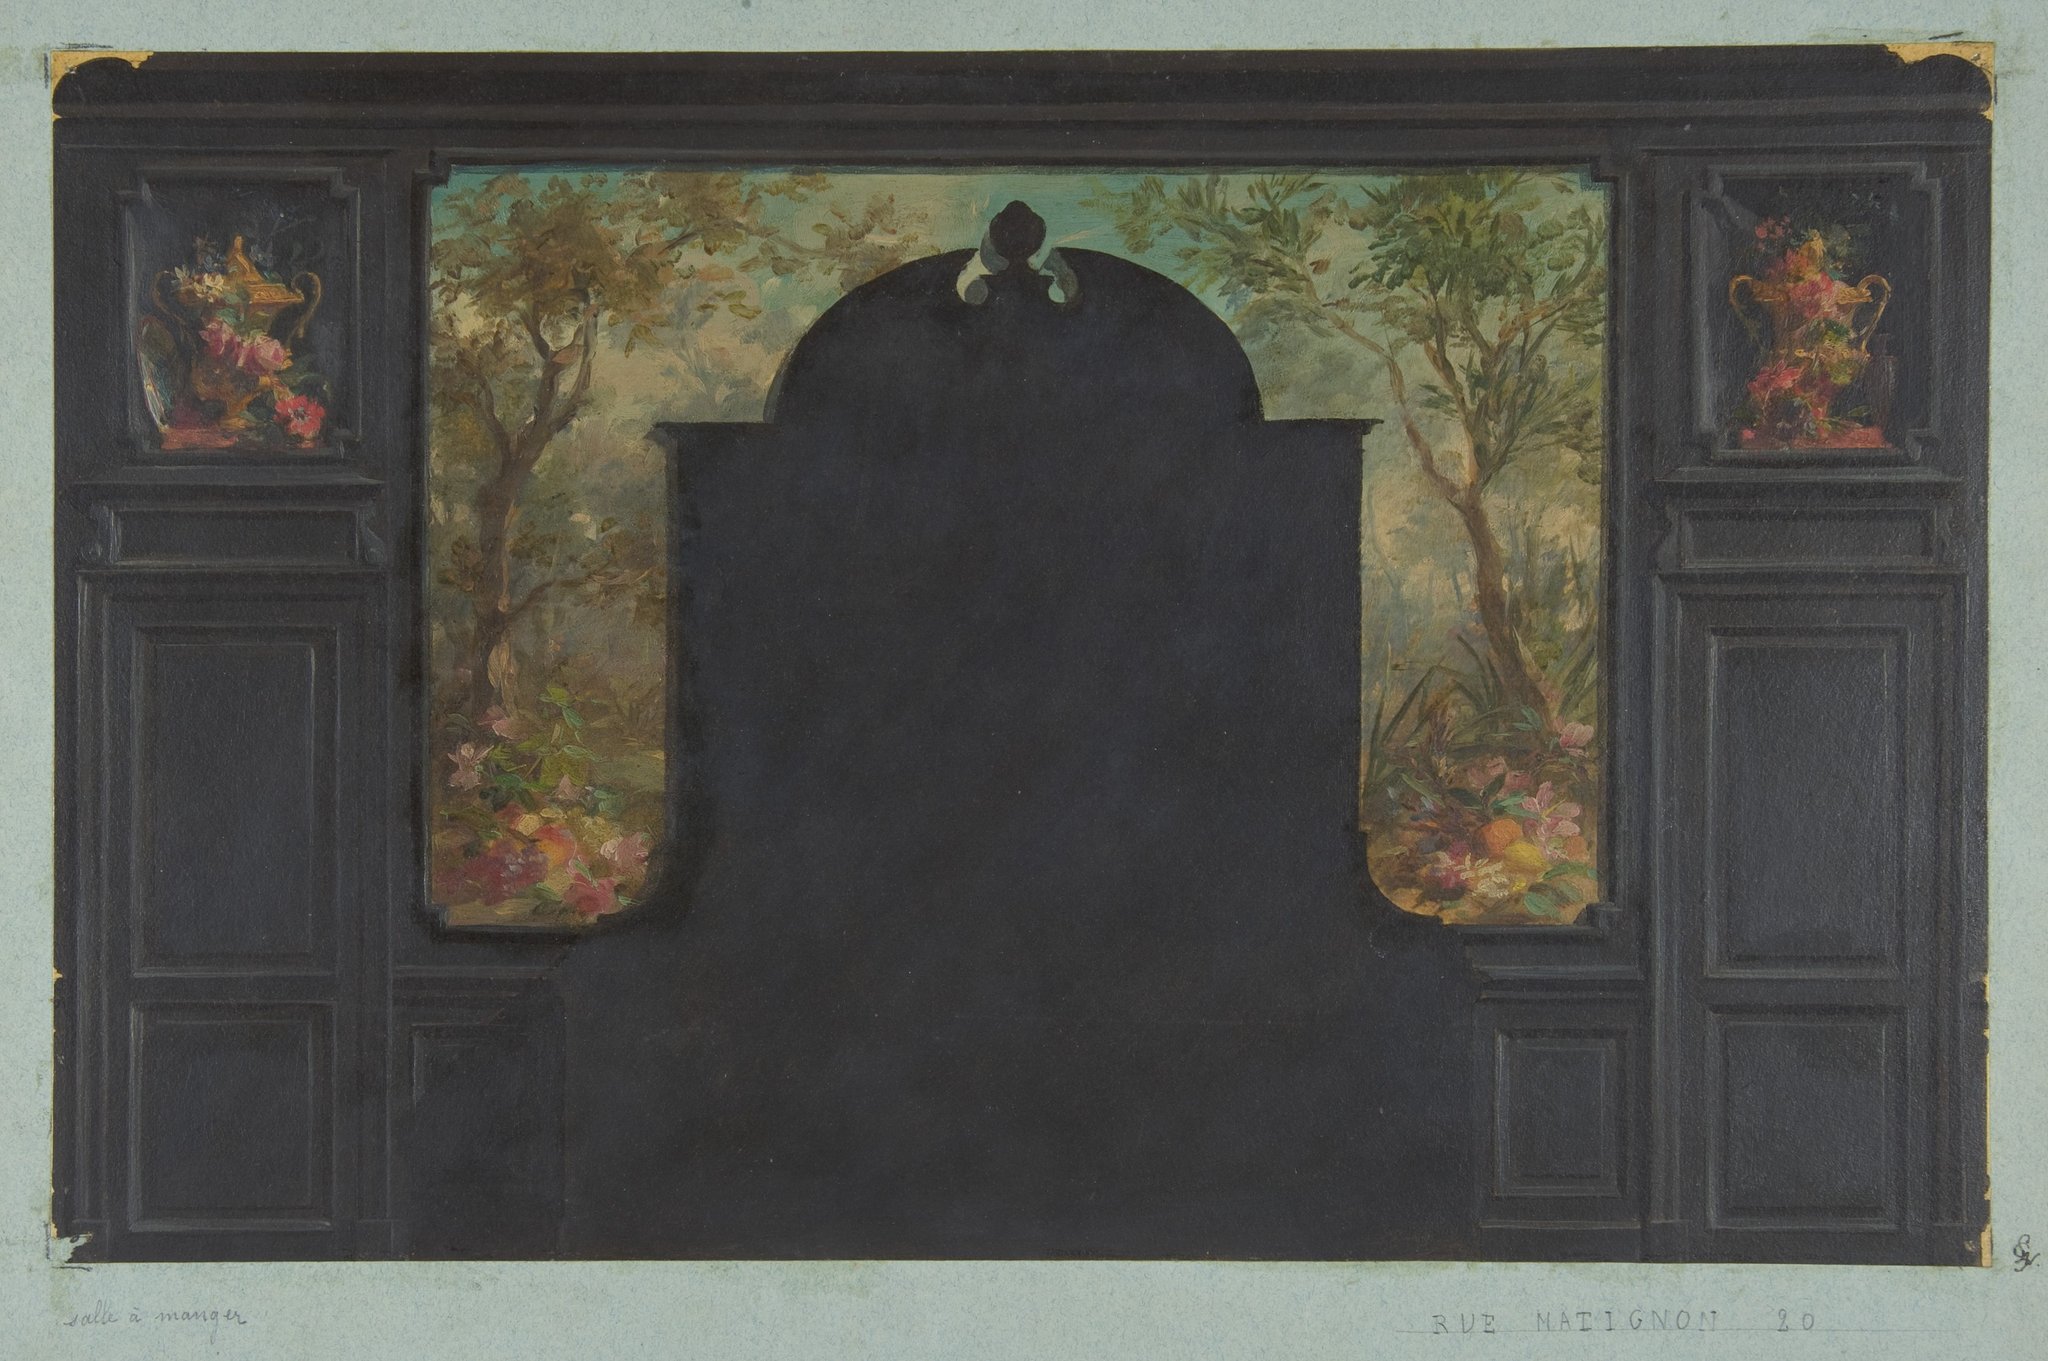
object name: drawing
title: Design for the decoration of the dining room, 20 rue Matignon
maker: jules-edmond-charles lachaise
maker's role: artist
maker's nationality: french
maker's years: 1897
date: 1851-1900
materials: gouache, paper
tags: architecture,trees